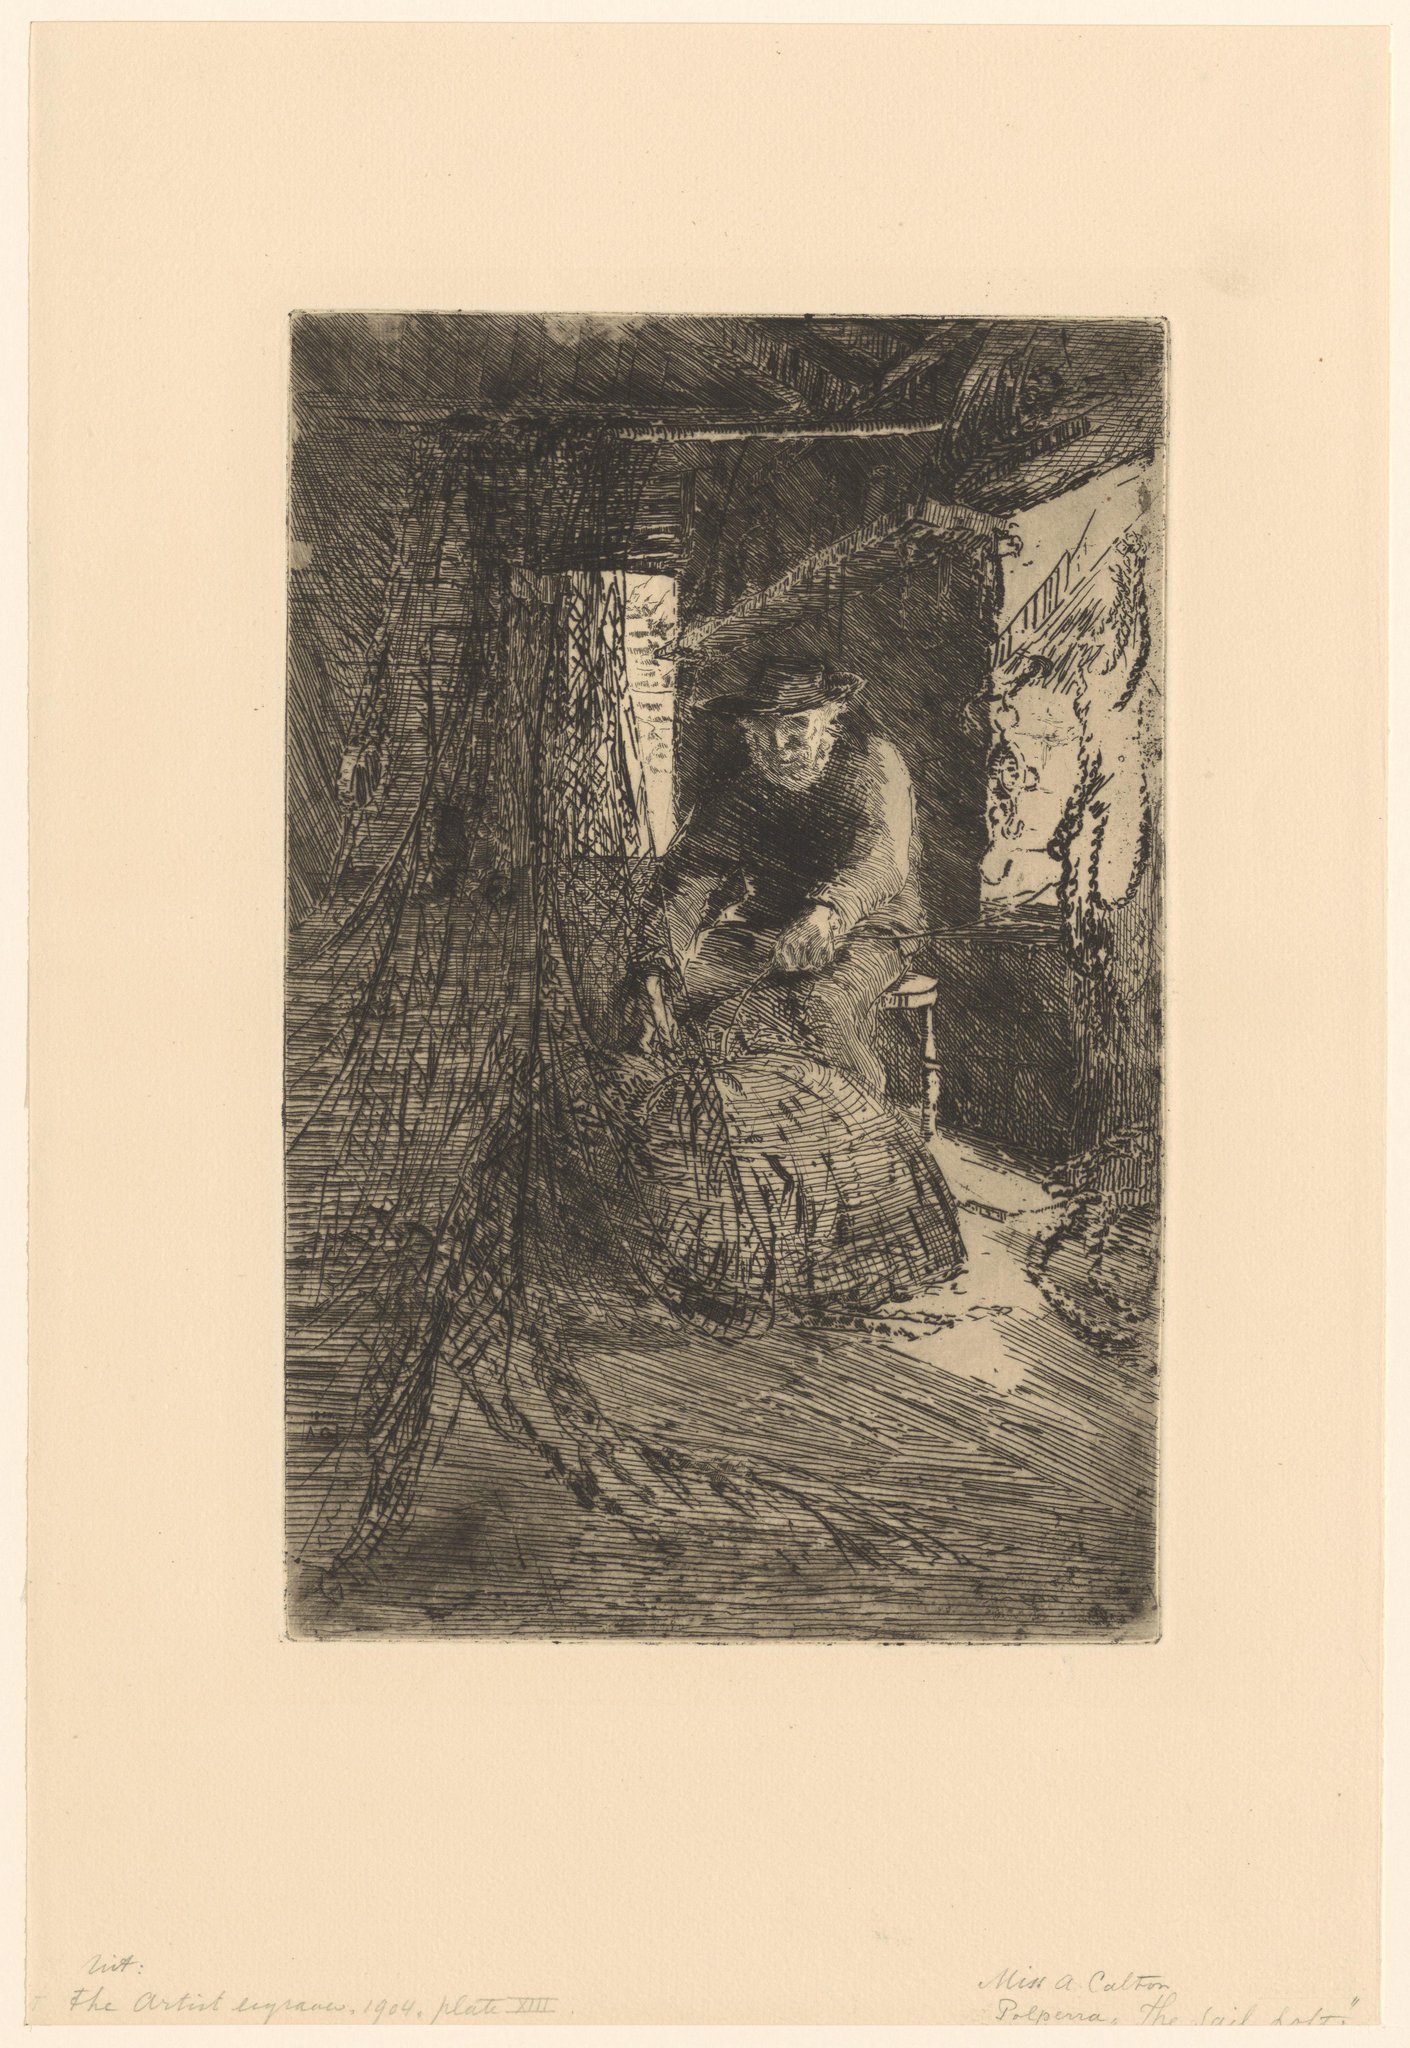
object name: print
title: Mandenvlechter in werkplaats in Polperro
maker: ada mary galton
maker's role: print maker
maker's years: 1873-1933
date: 1900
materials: paper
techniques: drypoint, etching, intaglio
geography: london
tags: fishing net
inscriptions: collector's mark: Lugt 2228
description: Prent ook gebruikt in: The Artist Engraver: A Quarterly Magazine of Original Work, 1904.